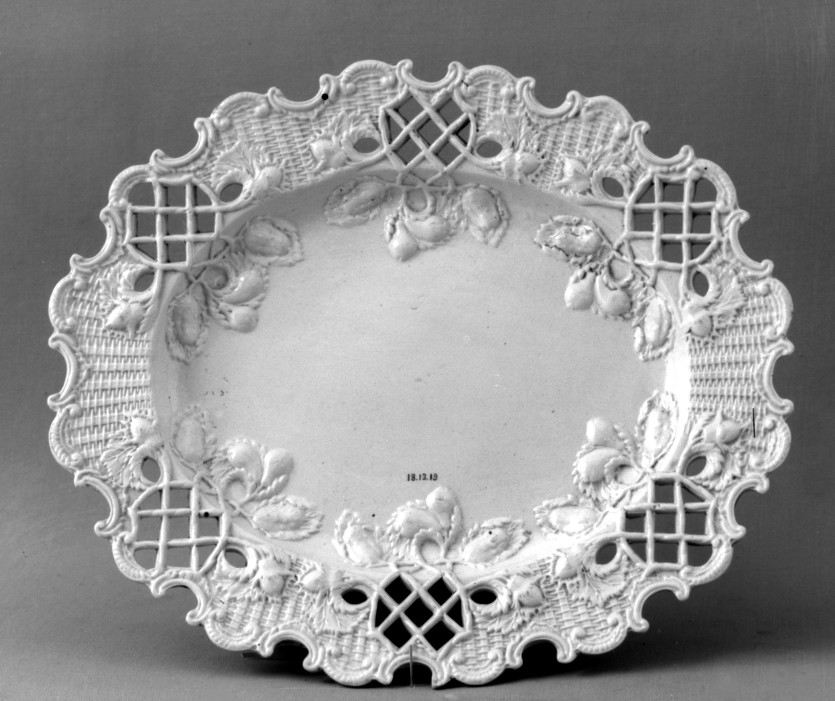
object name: stand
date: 1760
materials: stoneware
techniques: salt glaze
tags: fruit